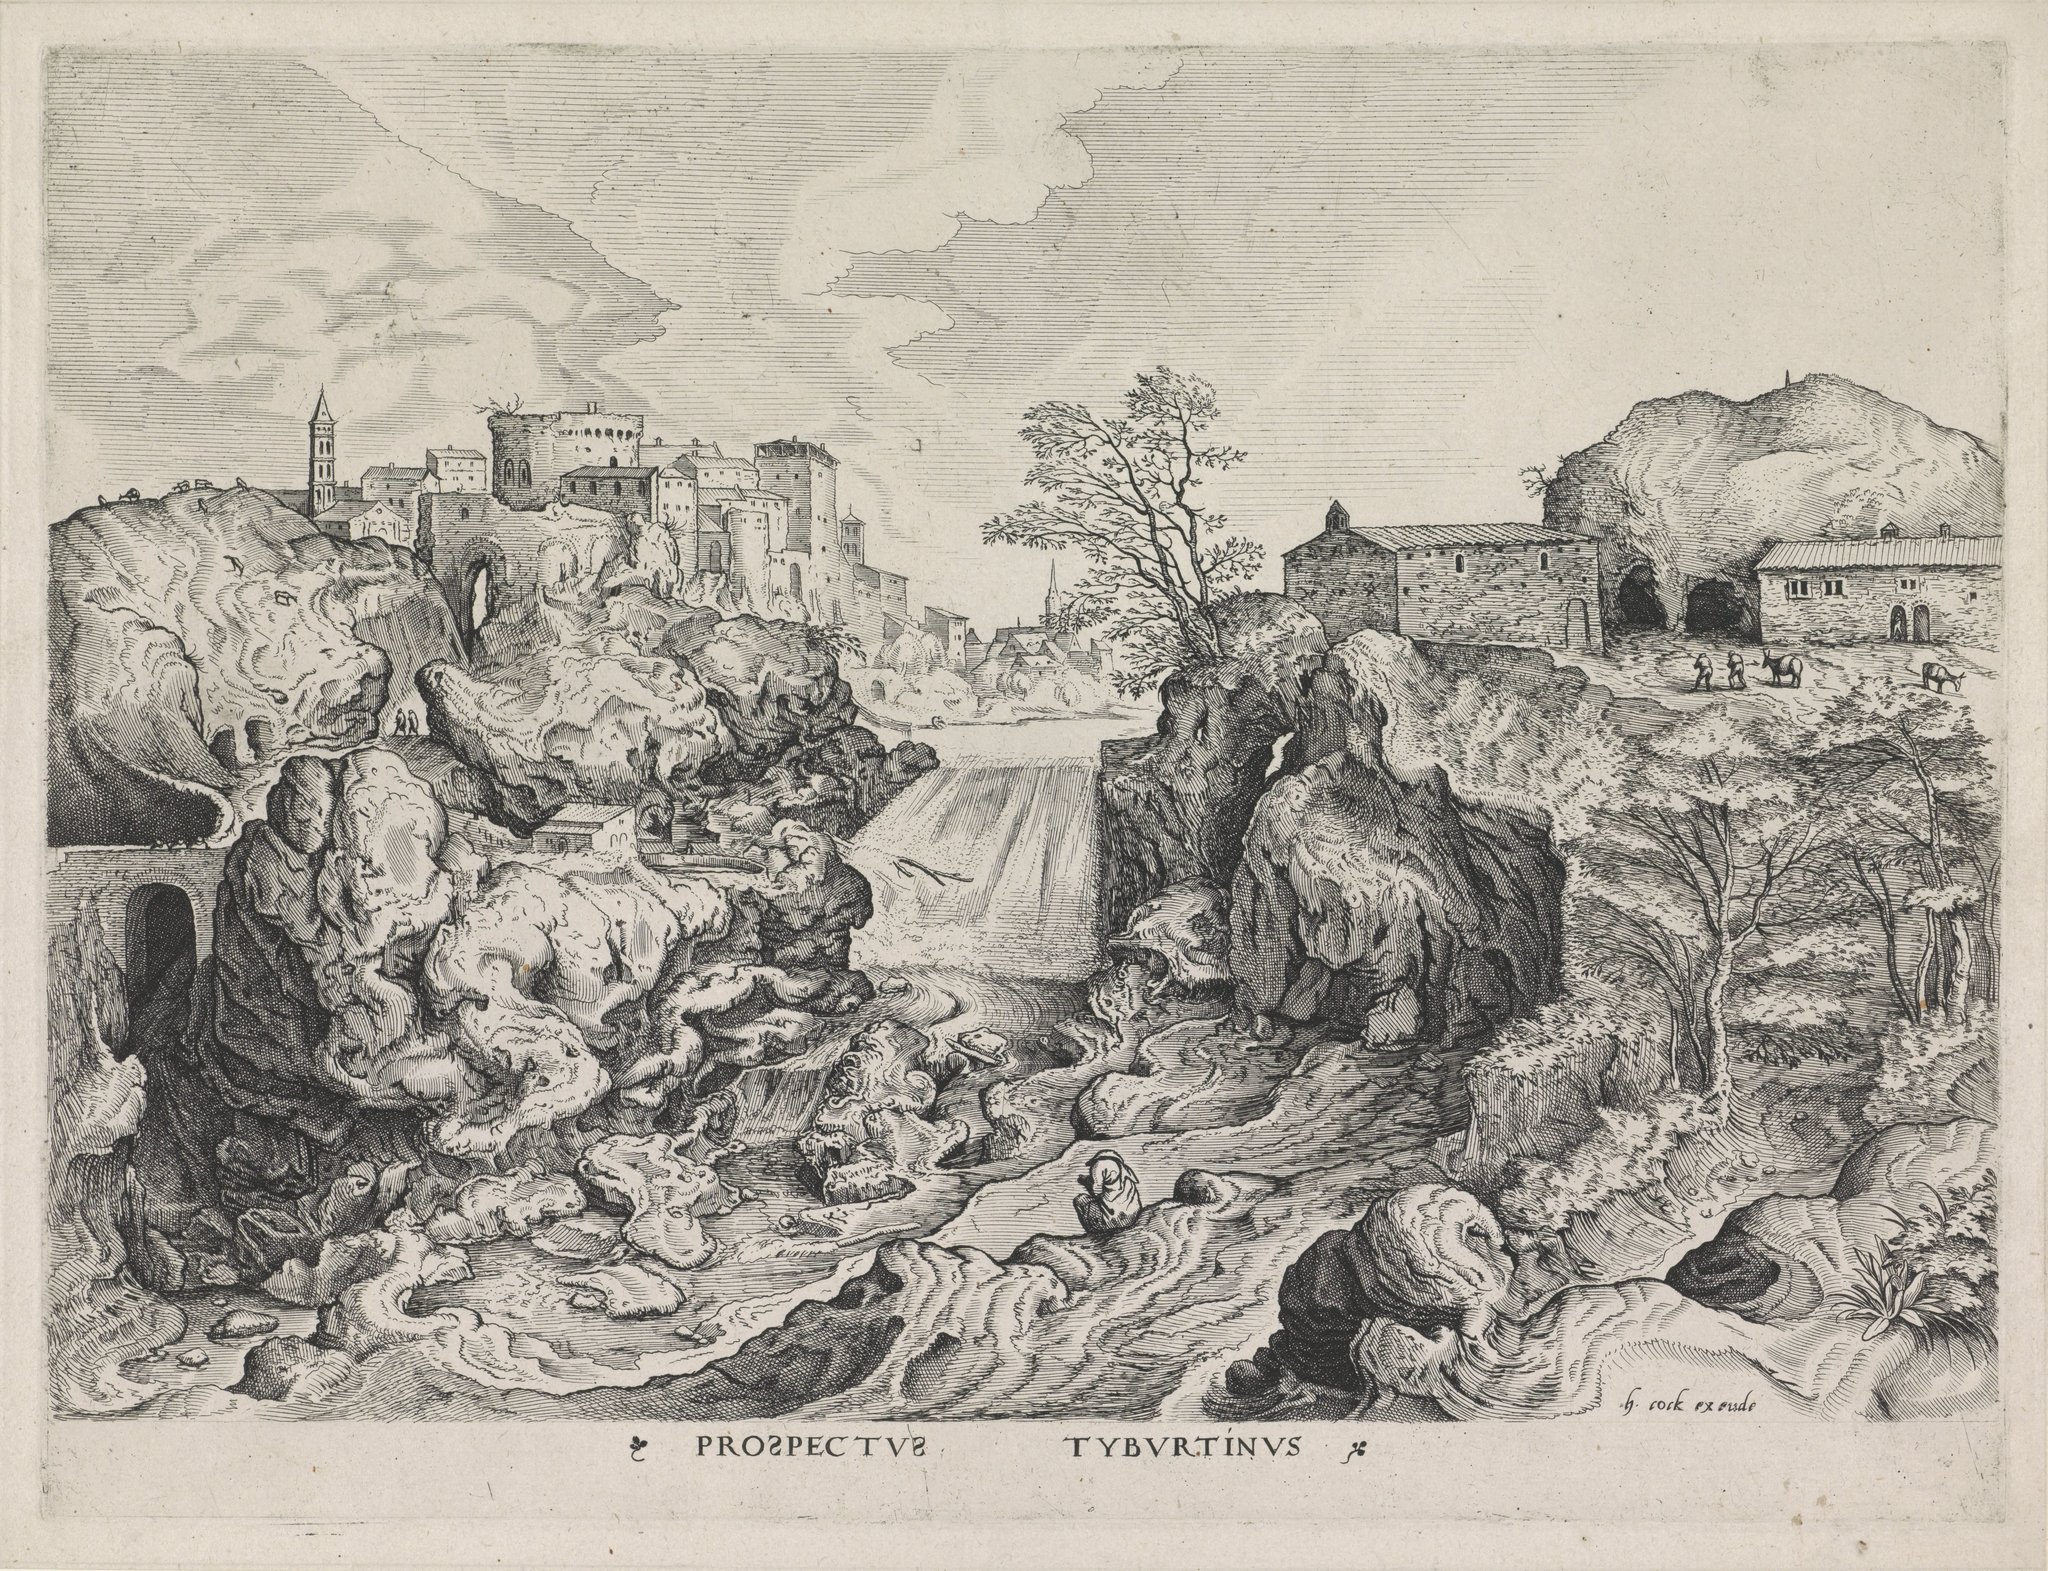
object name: print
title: Grote landschappen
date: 1553-1558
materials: paper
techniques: engraving, etching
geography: antwerp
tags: river, landscapes in the temperate zone, tivoli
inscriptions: collector's mark: Lugt 240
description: Gezicht op de rivier de Tiber bij Tivoli. In het midden van het landschap een waterval. Links Tivoli.